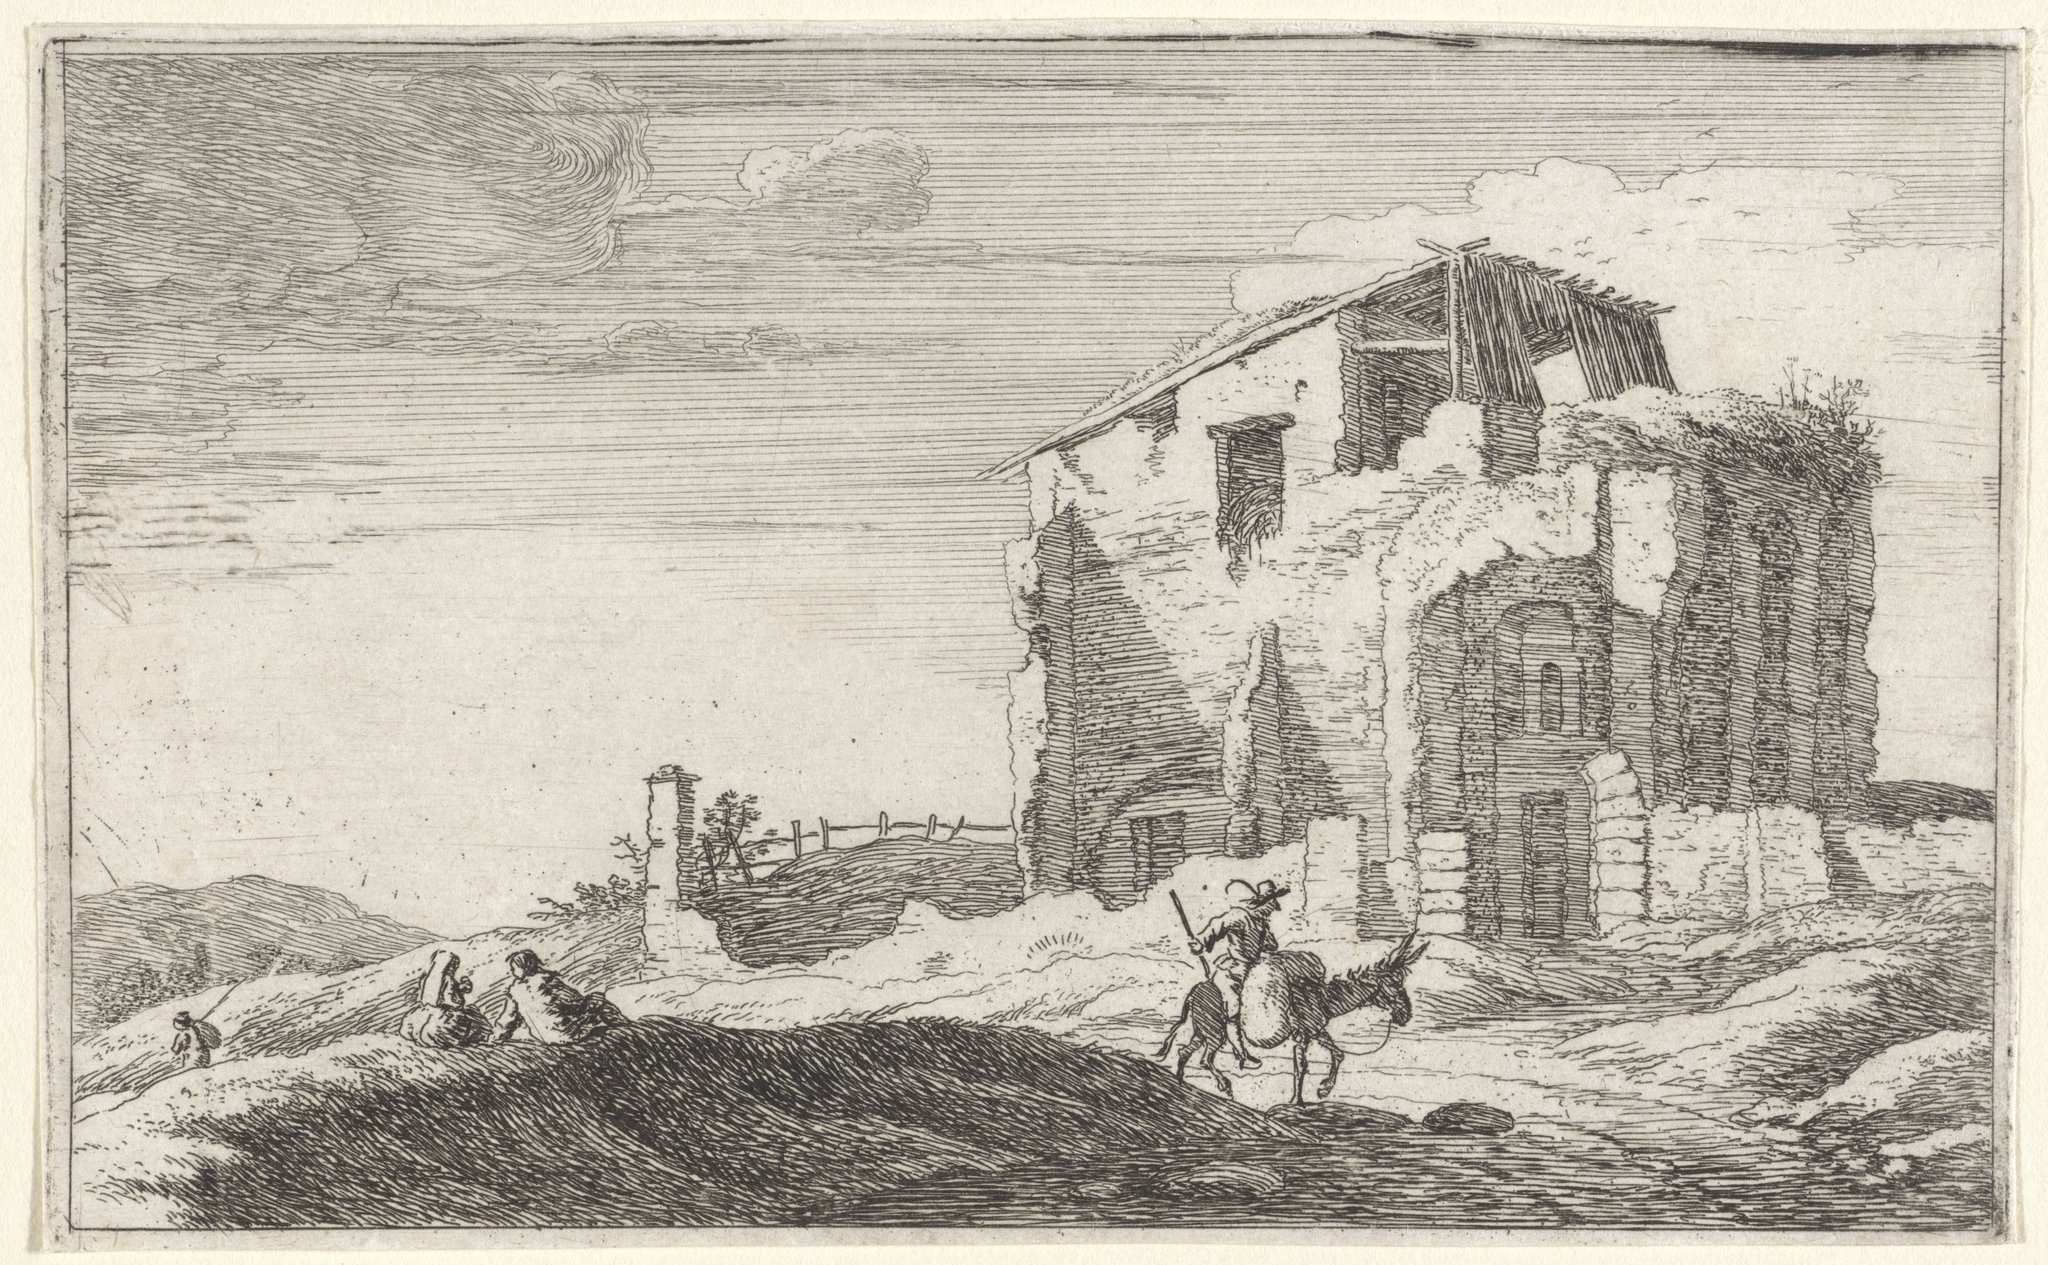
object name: print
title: Gezicht op een ruïne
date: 1629-1655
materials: paper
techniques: etching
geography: paris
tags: landscapes, landscape with ruins, ruin of a dwelling, house, castle, etc., rome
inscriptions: collector's mark: Lugt 240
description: Wandelaars en een ruiter voor een ruïne in (de directe omgeving van) Rome.